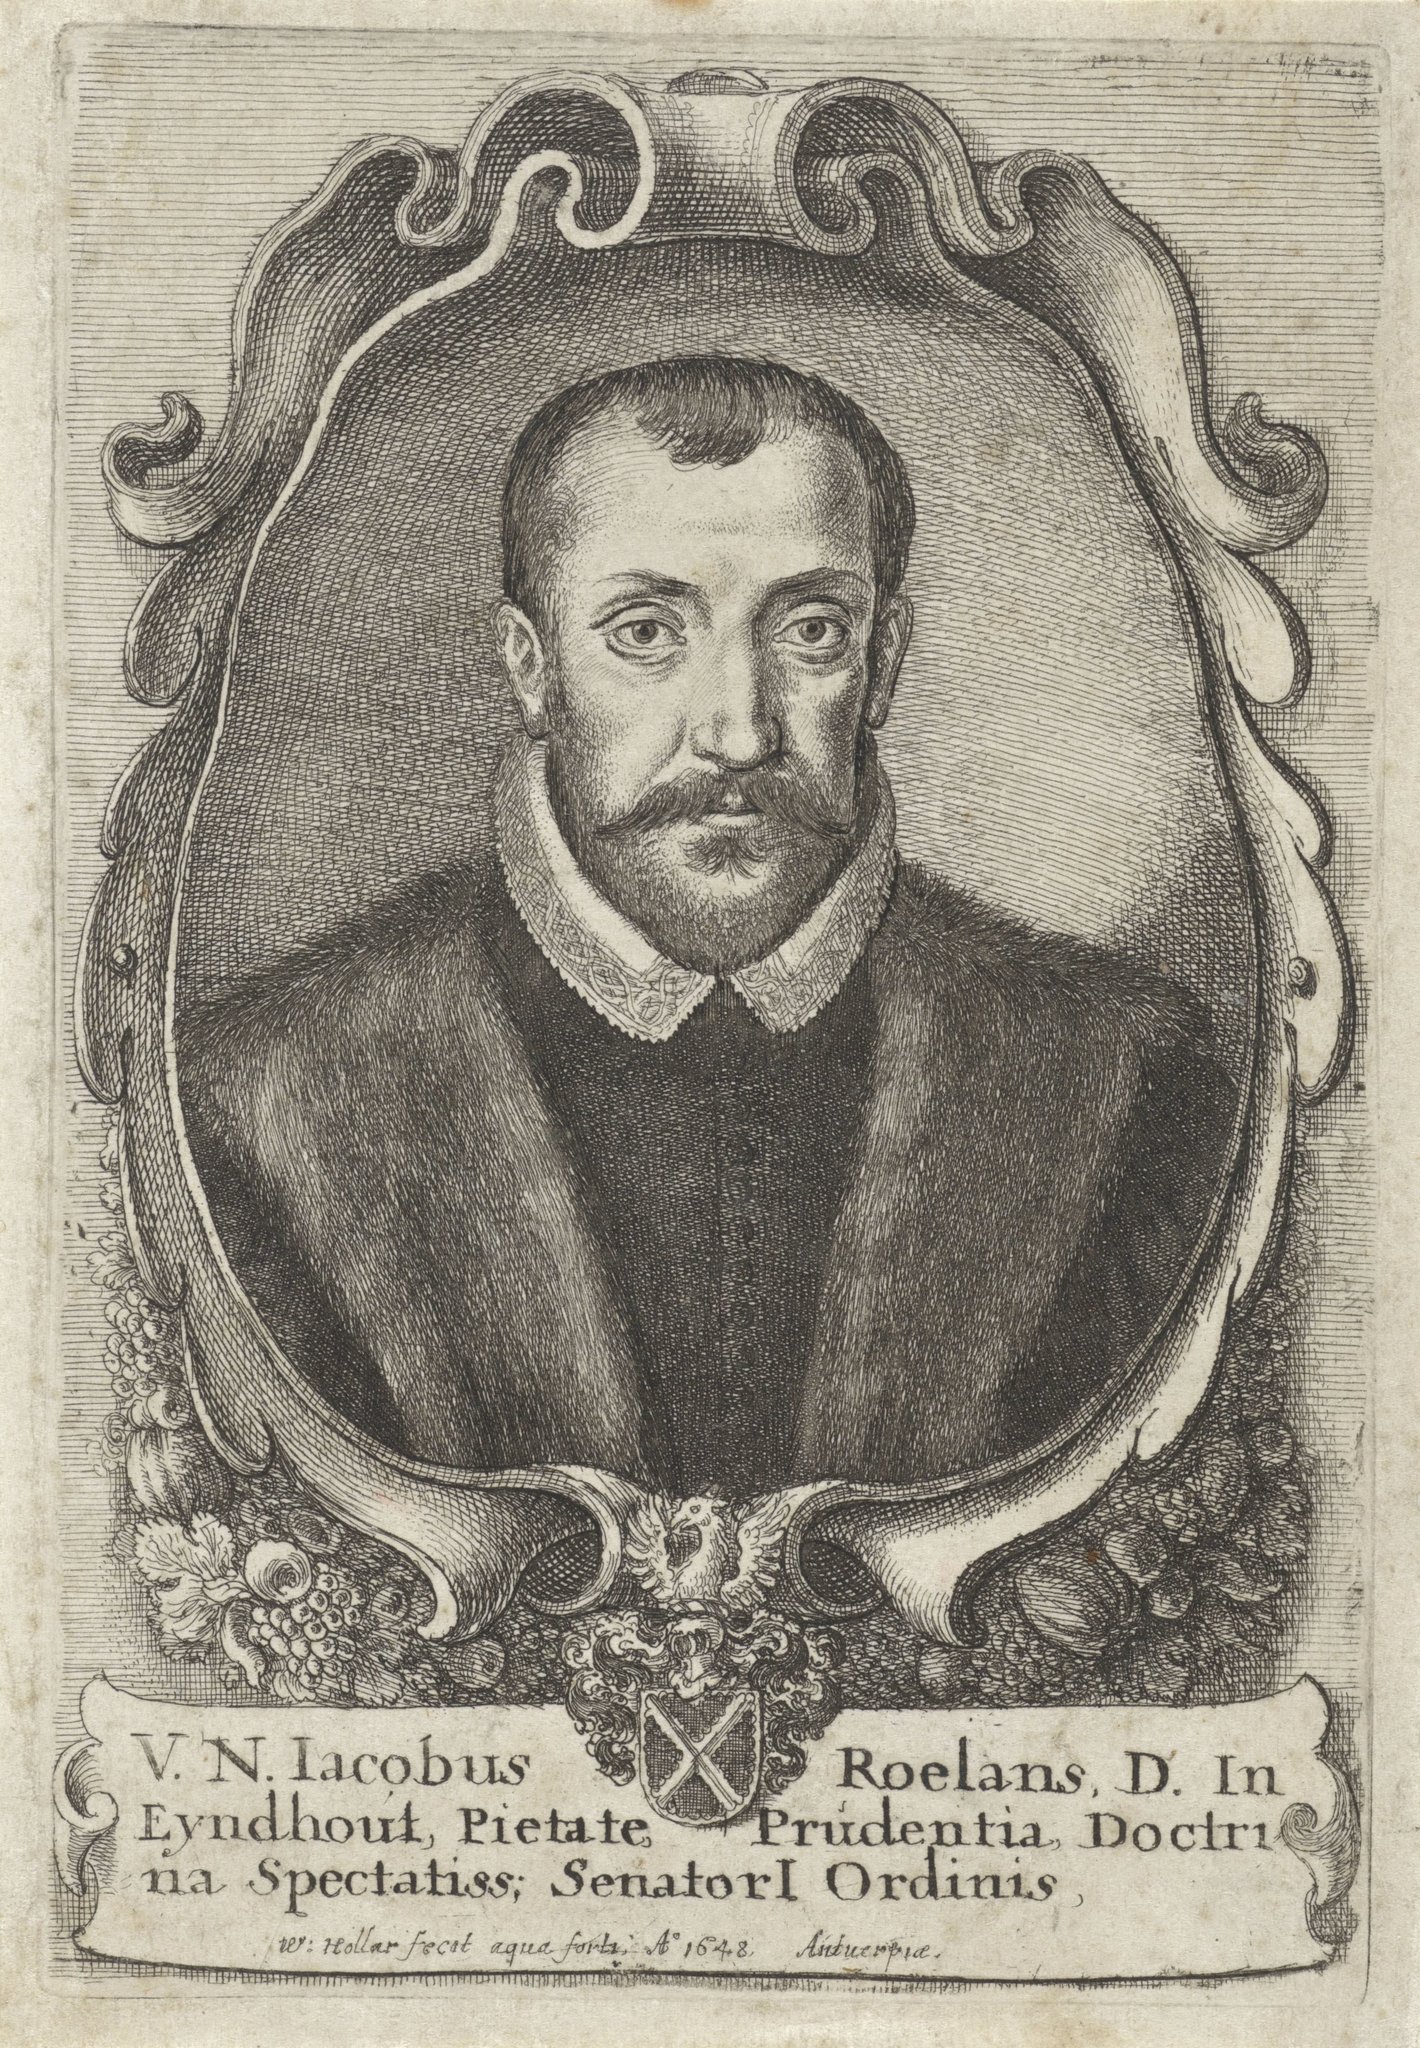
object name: print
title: Portretten van leden van de familie Roelants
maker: wenceslaus hollar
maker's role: draughtsman, print maker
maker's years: 1607-1677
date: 1648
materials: paper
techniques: etching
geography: antwerp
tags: jurist, raadslid, jacob roelants (1568-1651)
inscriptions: collector's mark: Lugt 2228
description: Jacob Roelants, jurist en raadslid te Mechelen.